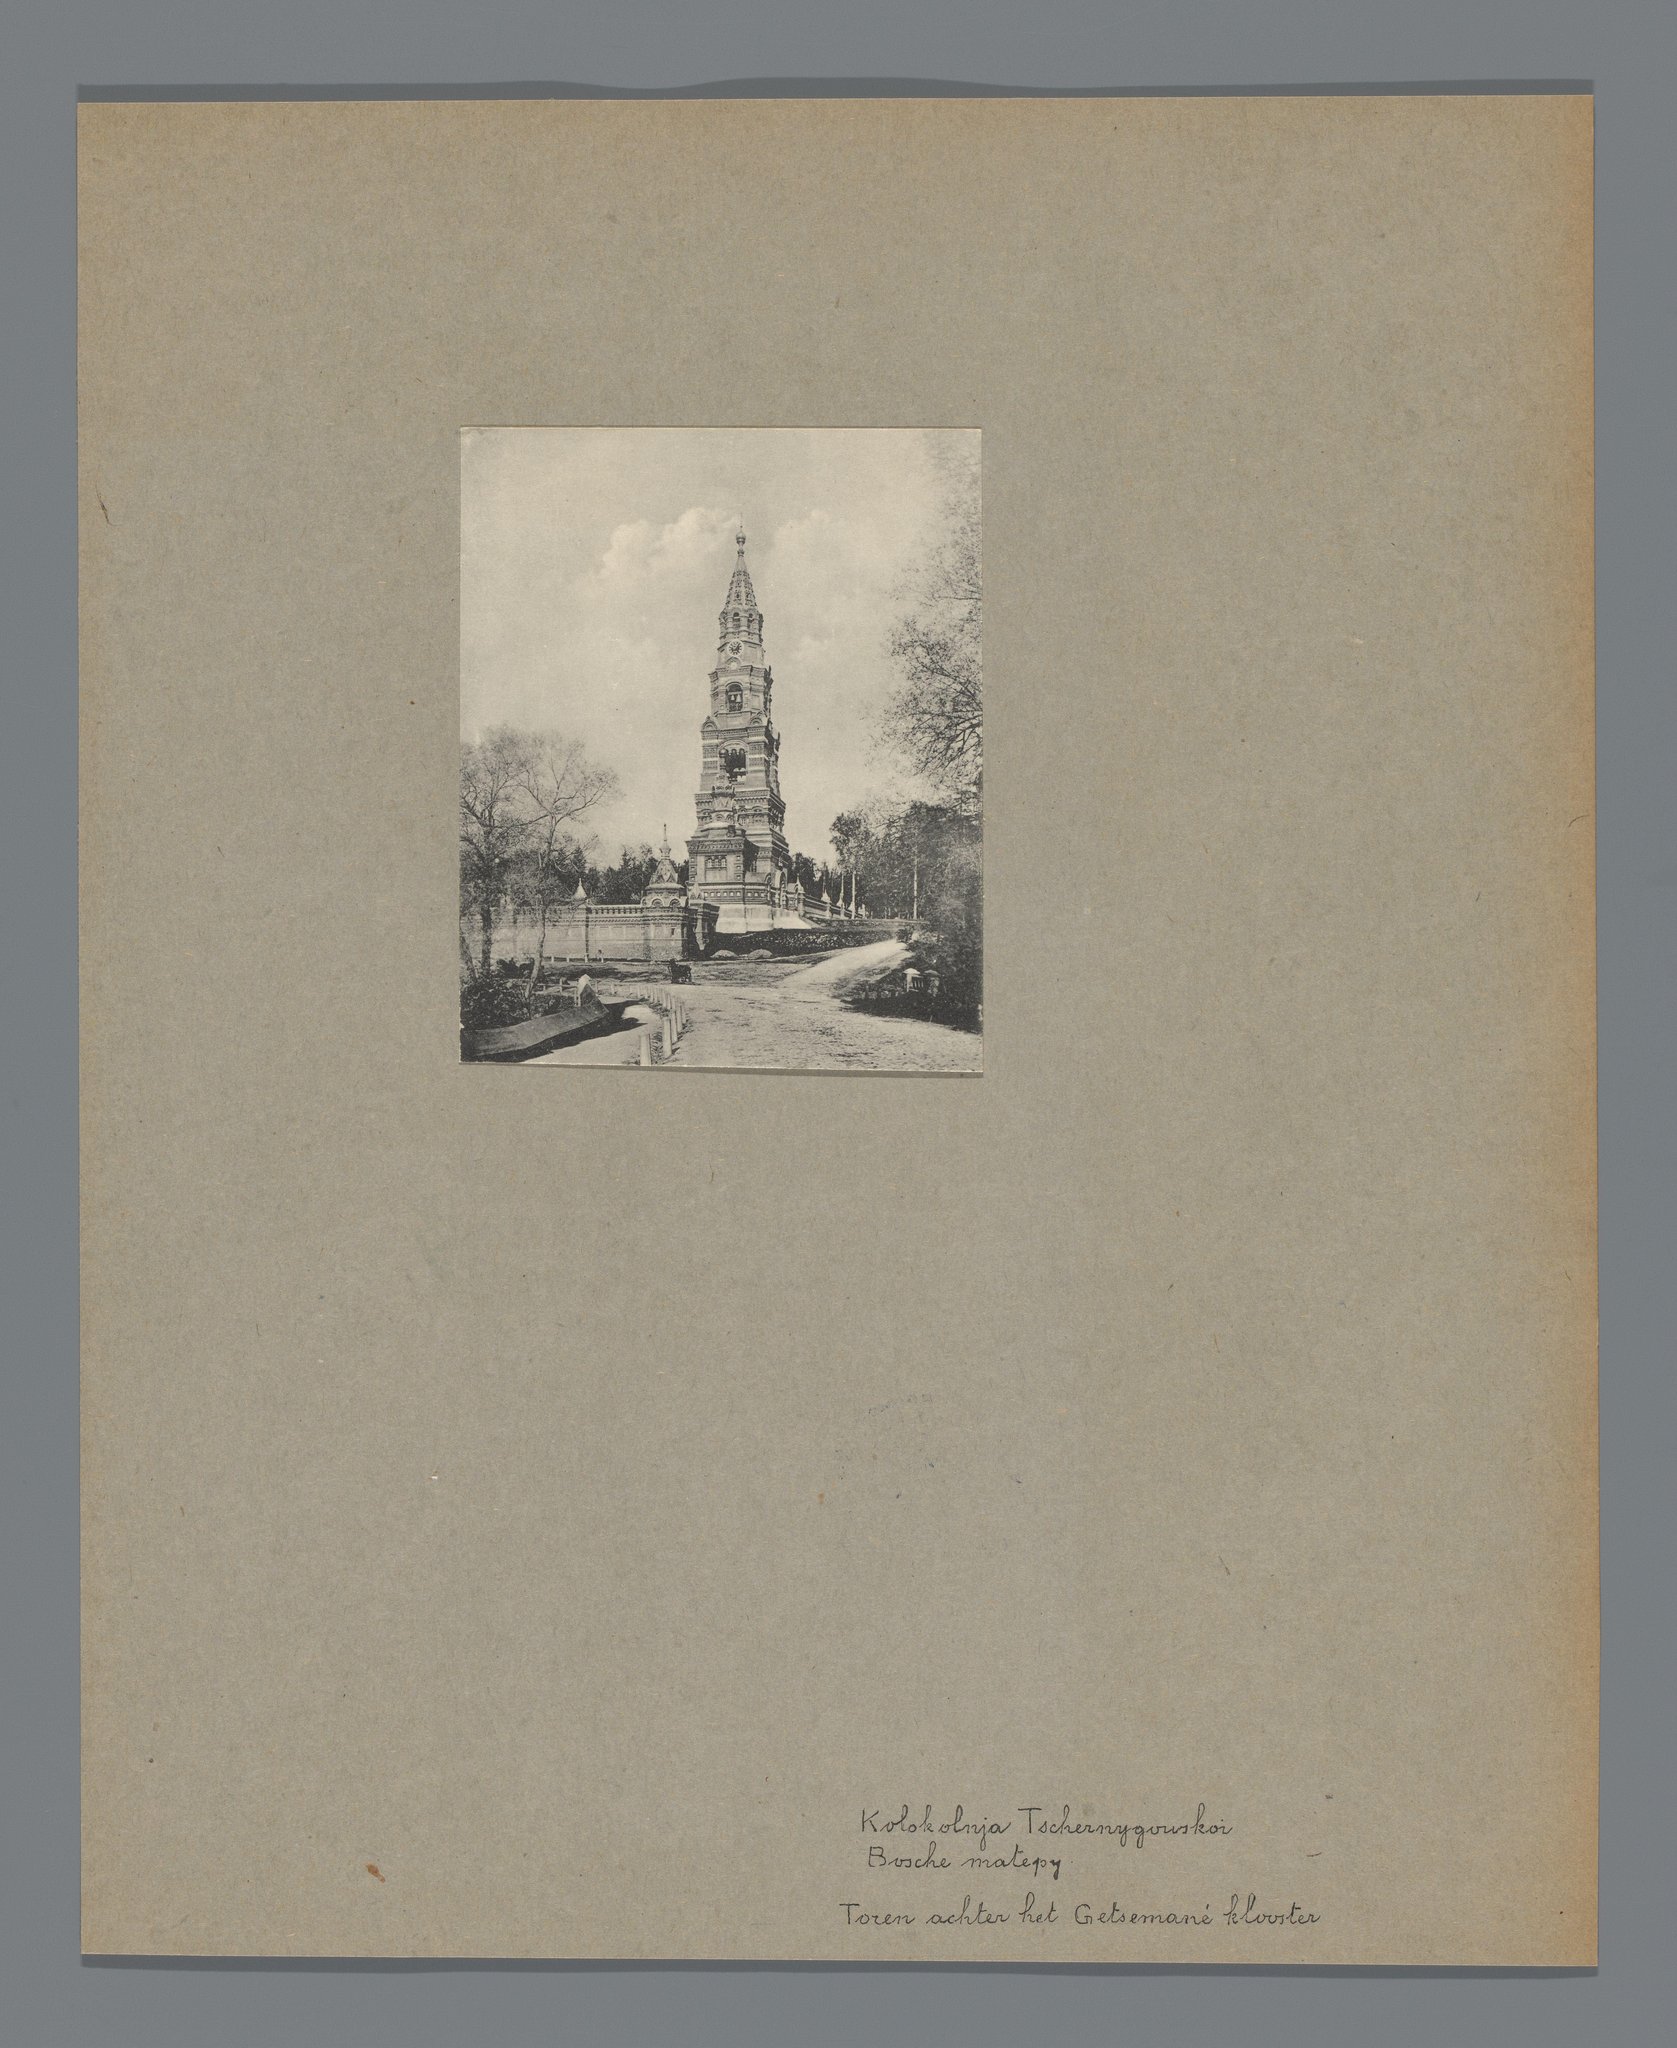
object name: photograph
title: Kolkonja Tschernygouskoi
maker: Anonymous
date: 1860-1925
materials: photographic support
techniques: photograph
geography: russia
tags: russia